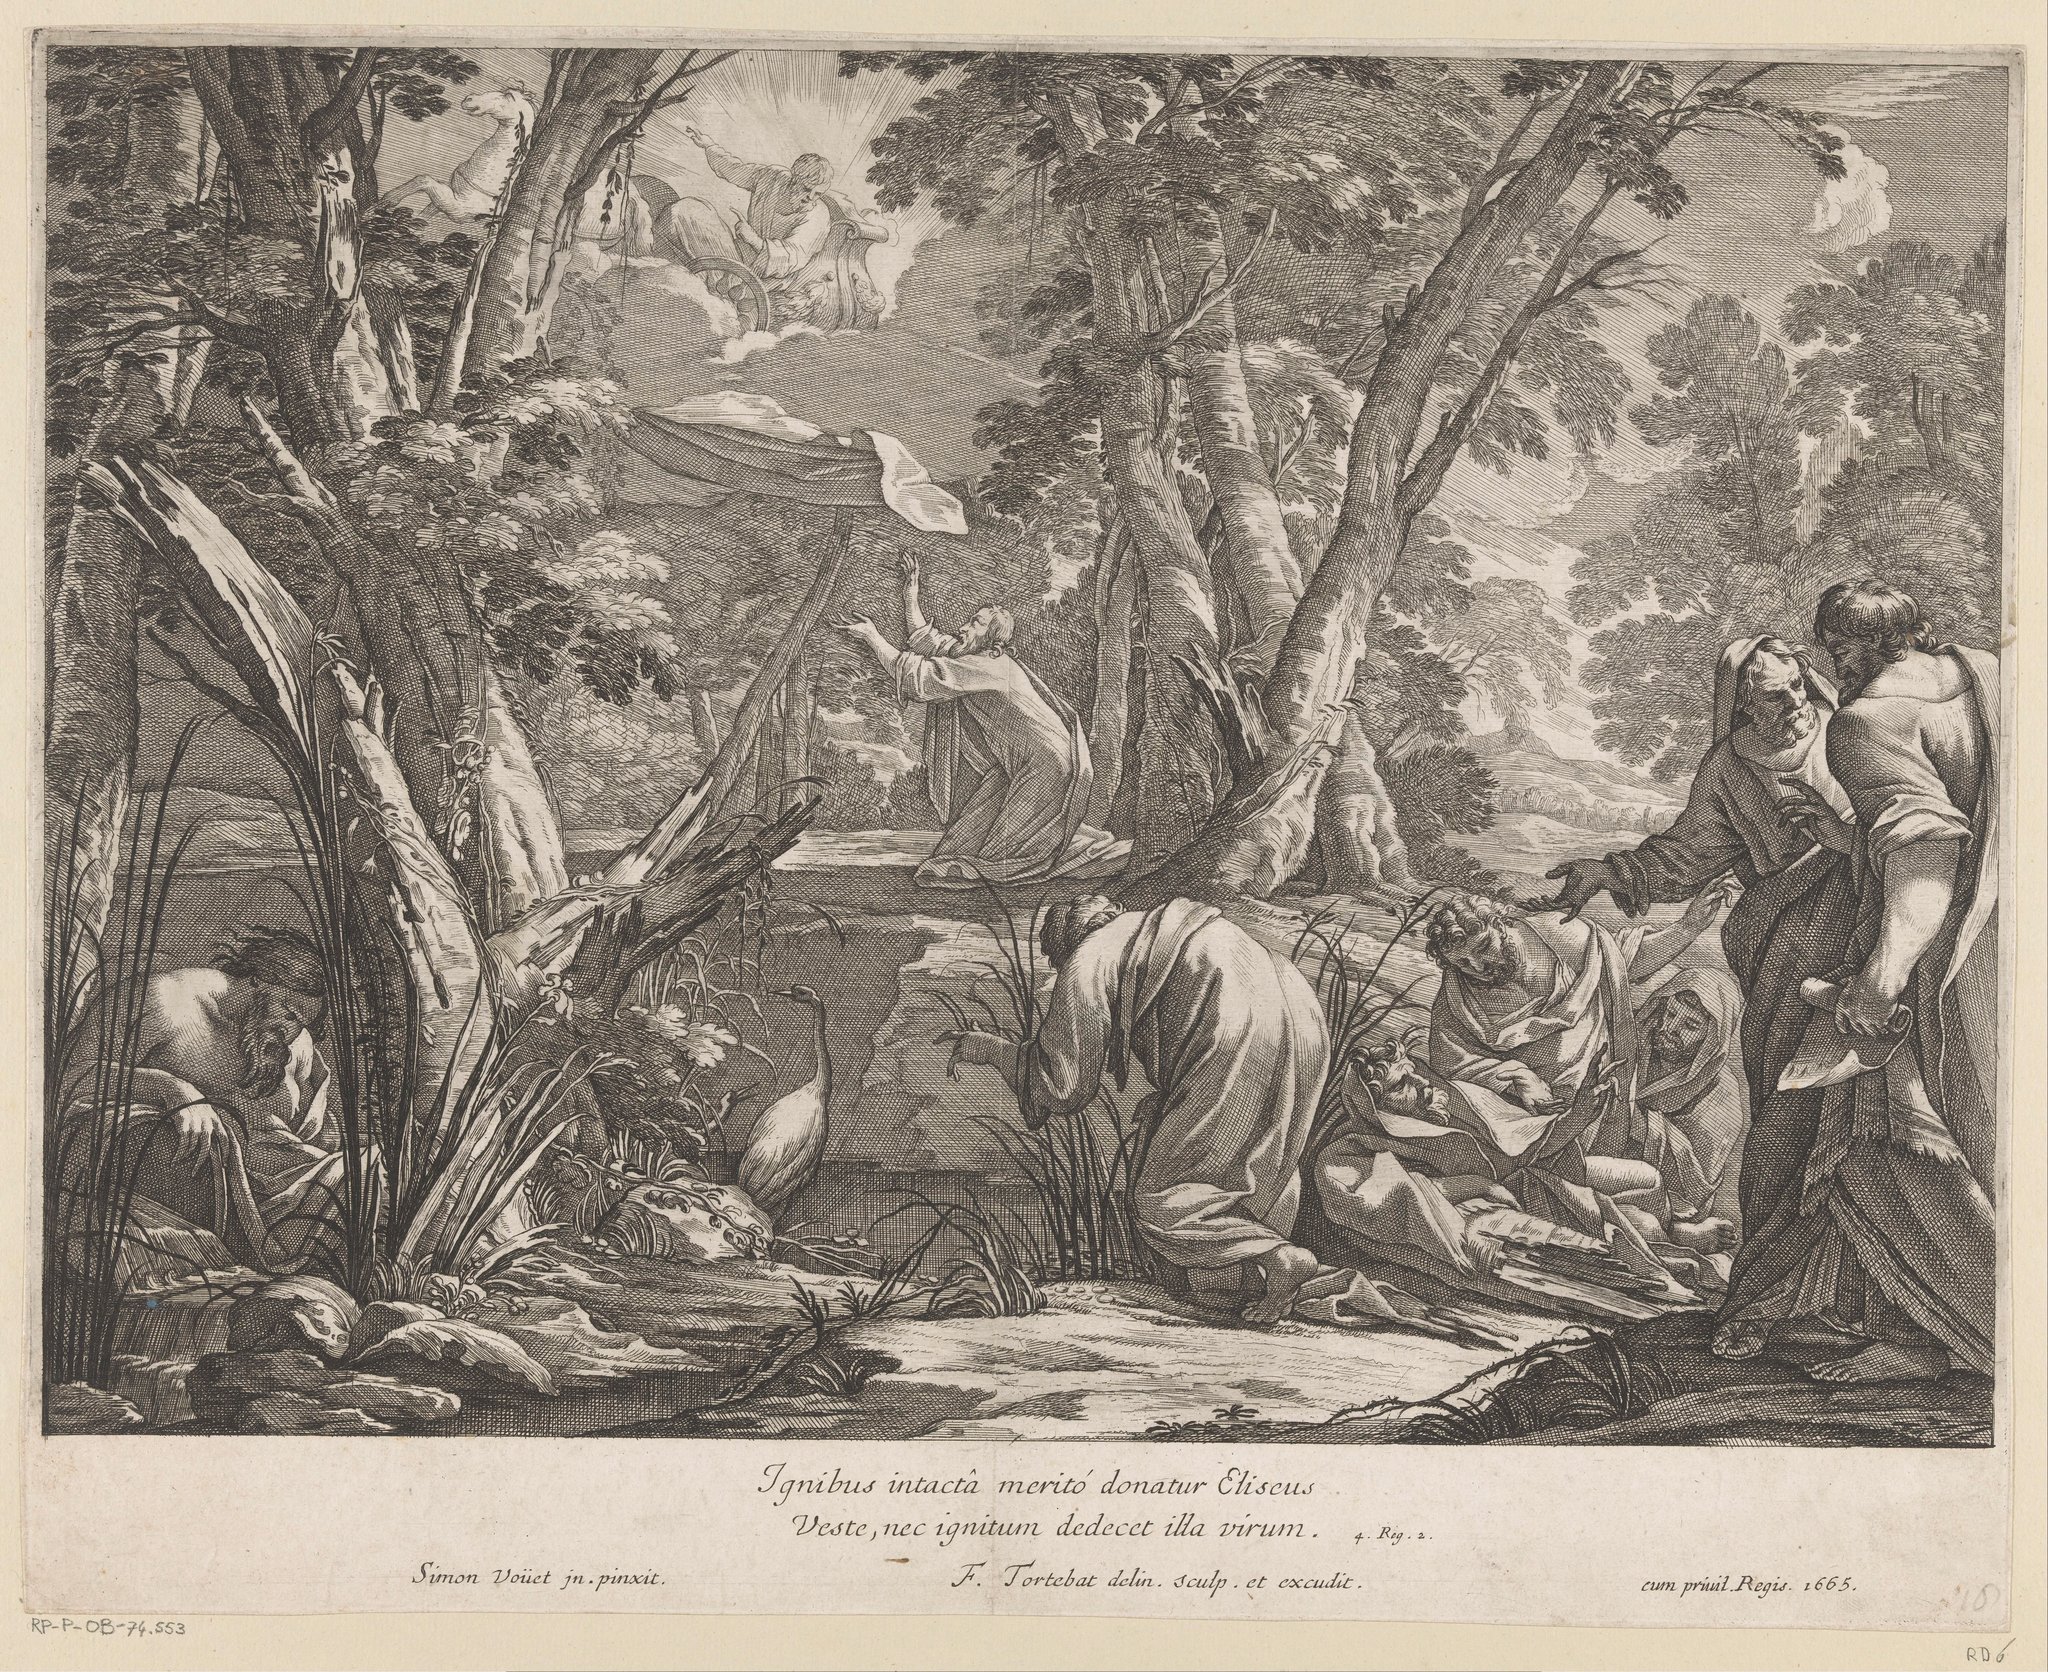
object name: print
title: Elias in de vurige wagen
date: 1665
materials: paper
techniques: engraving, etching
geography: france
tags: the ascension of elijah (2 kings 2:1-18)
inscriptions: collector's mark: Lugt 240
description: Boomlandschap met figuren aan de waterkant. Op de achtergrond aanschouwt Elisa de hemelvaart van Elias.